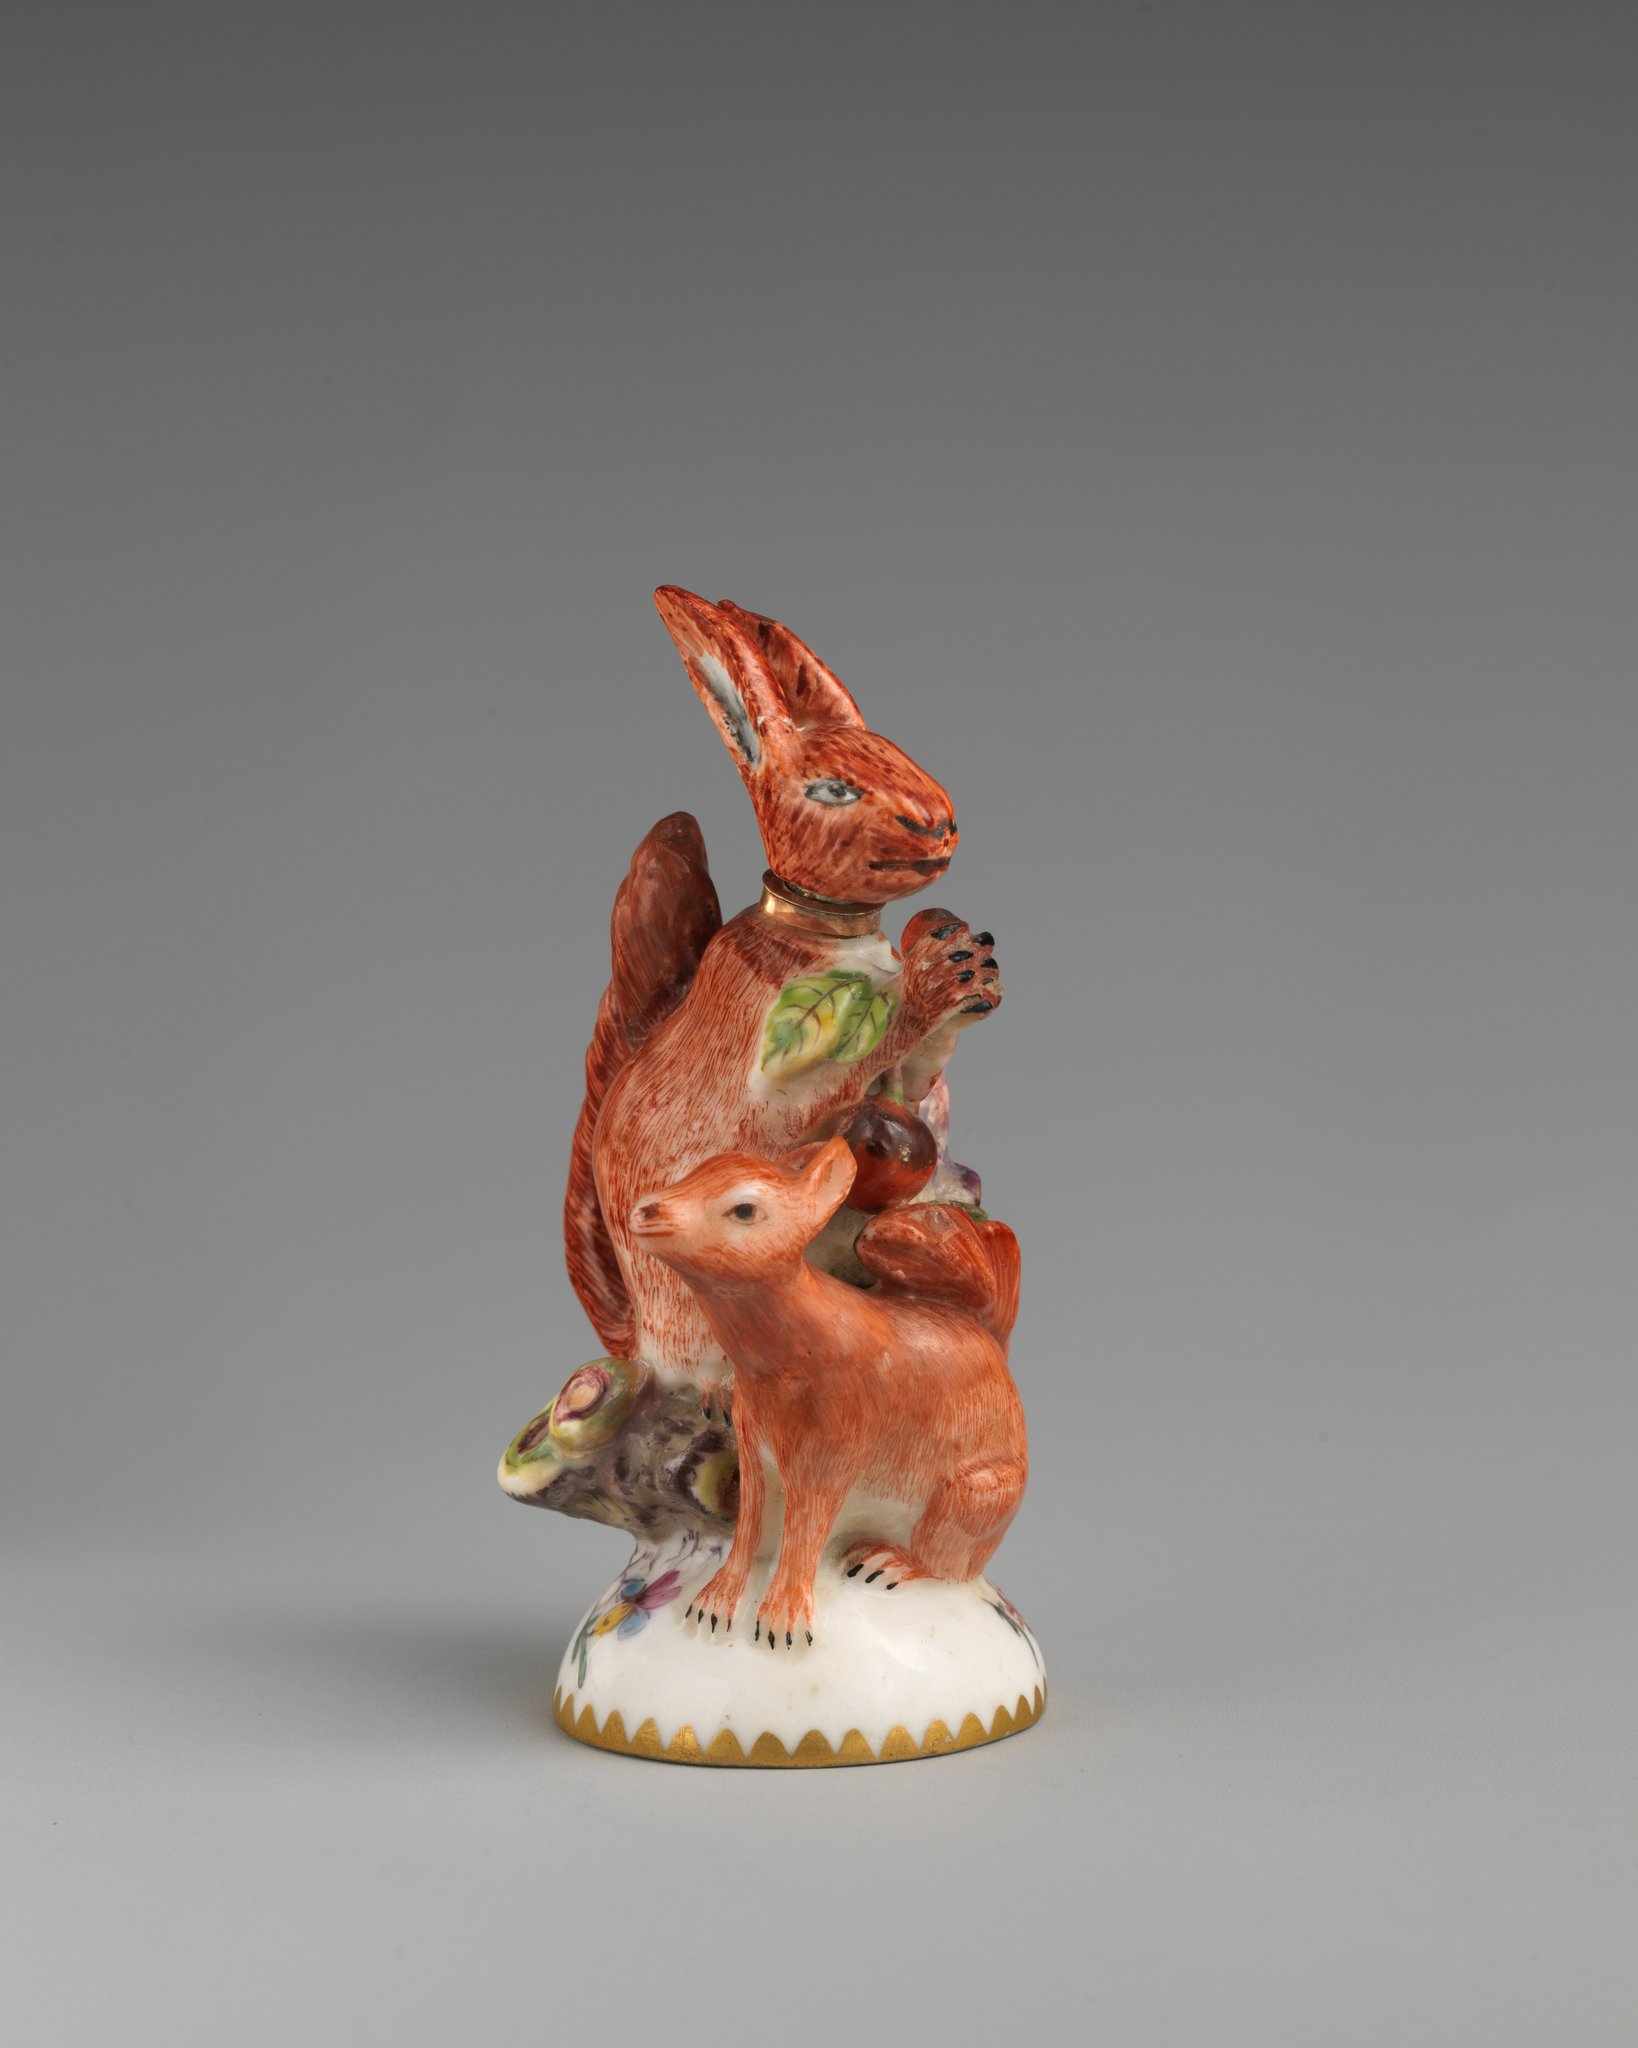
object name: scent bottle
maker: chelsea porcelain manufactory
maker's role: factory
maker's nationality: british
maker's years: 1744-1784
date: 1756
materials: soft paste porcelain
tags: animals,fruit,squirrels